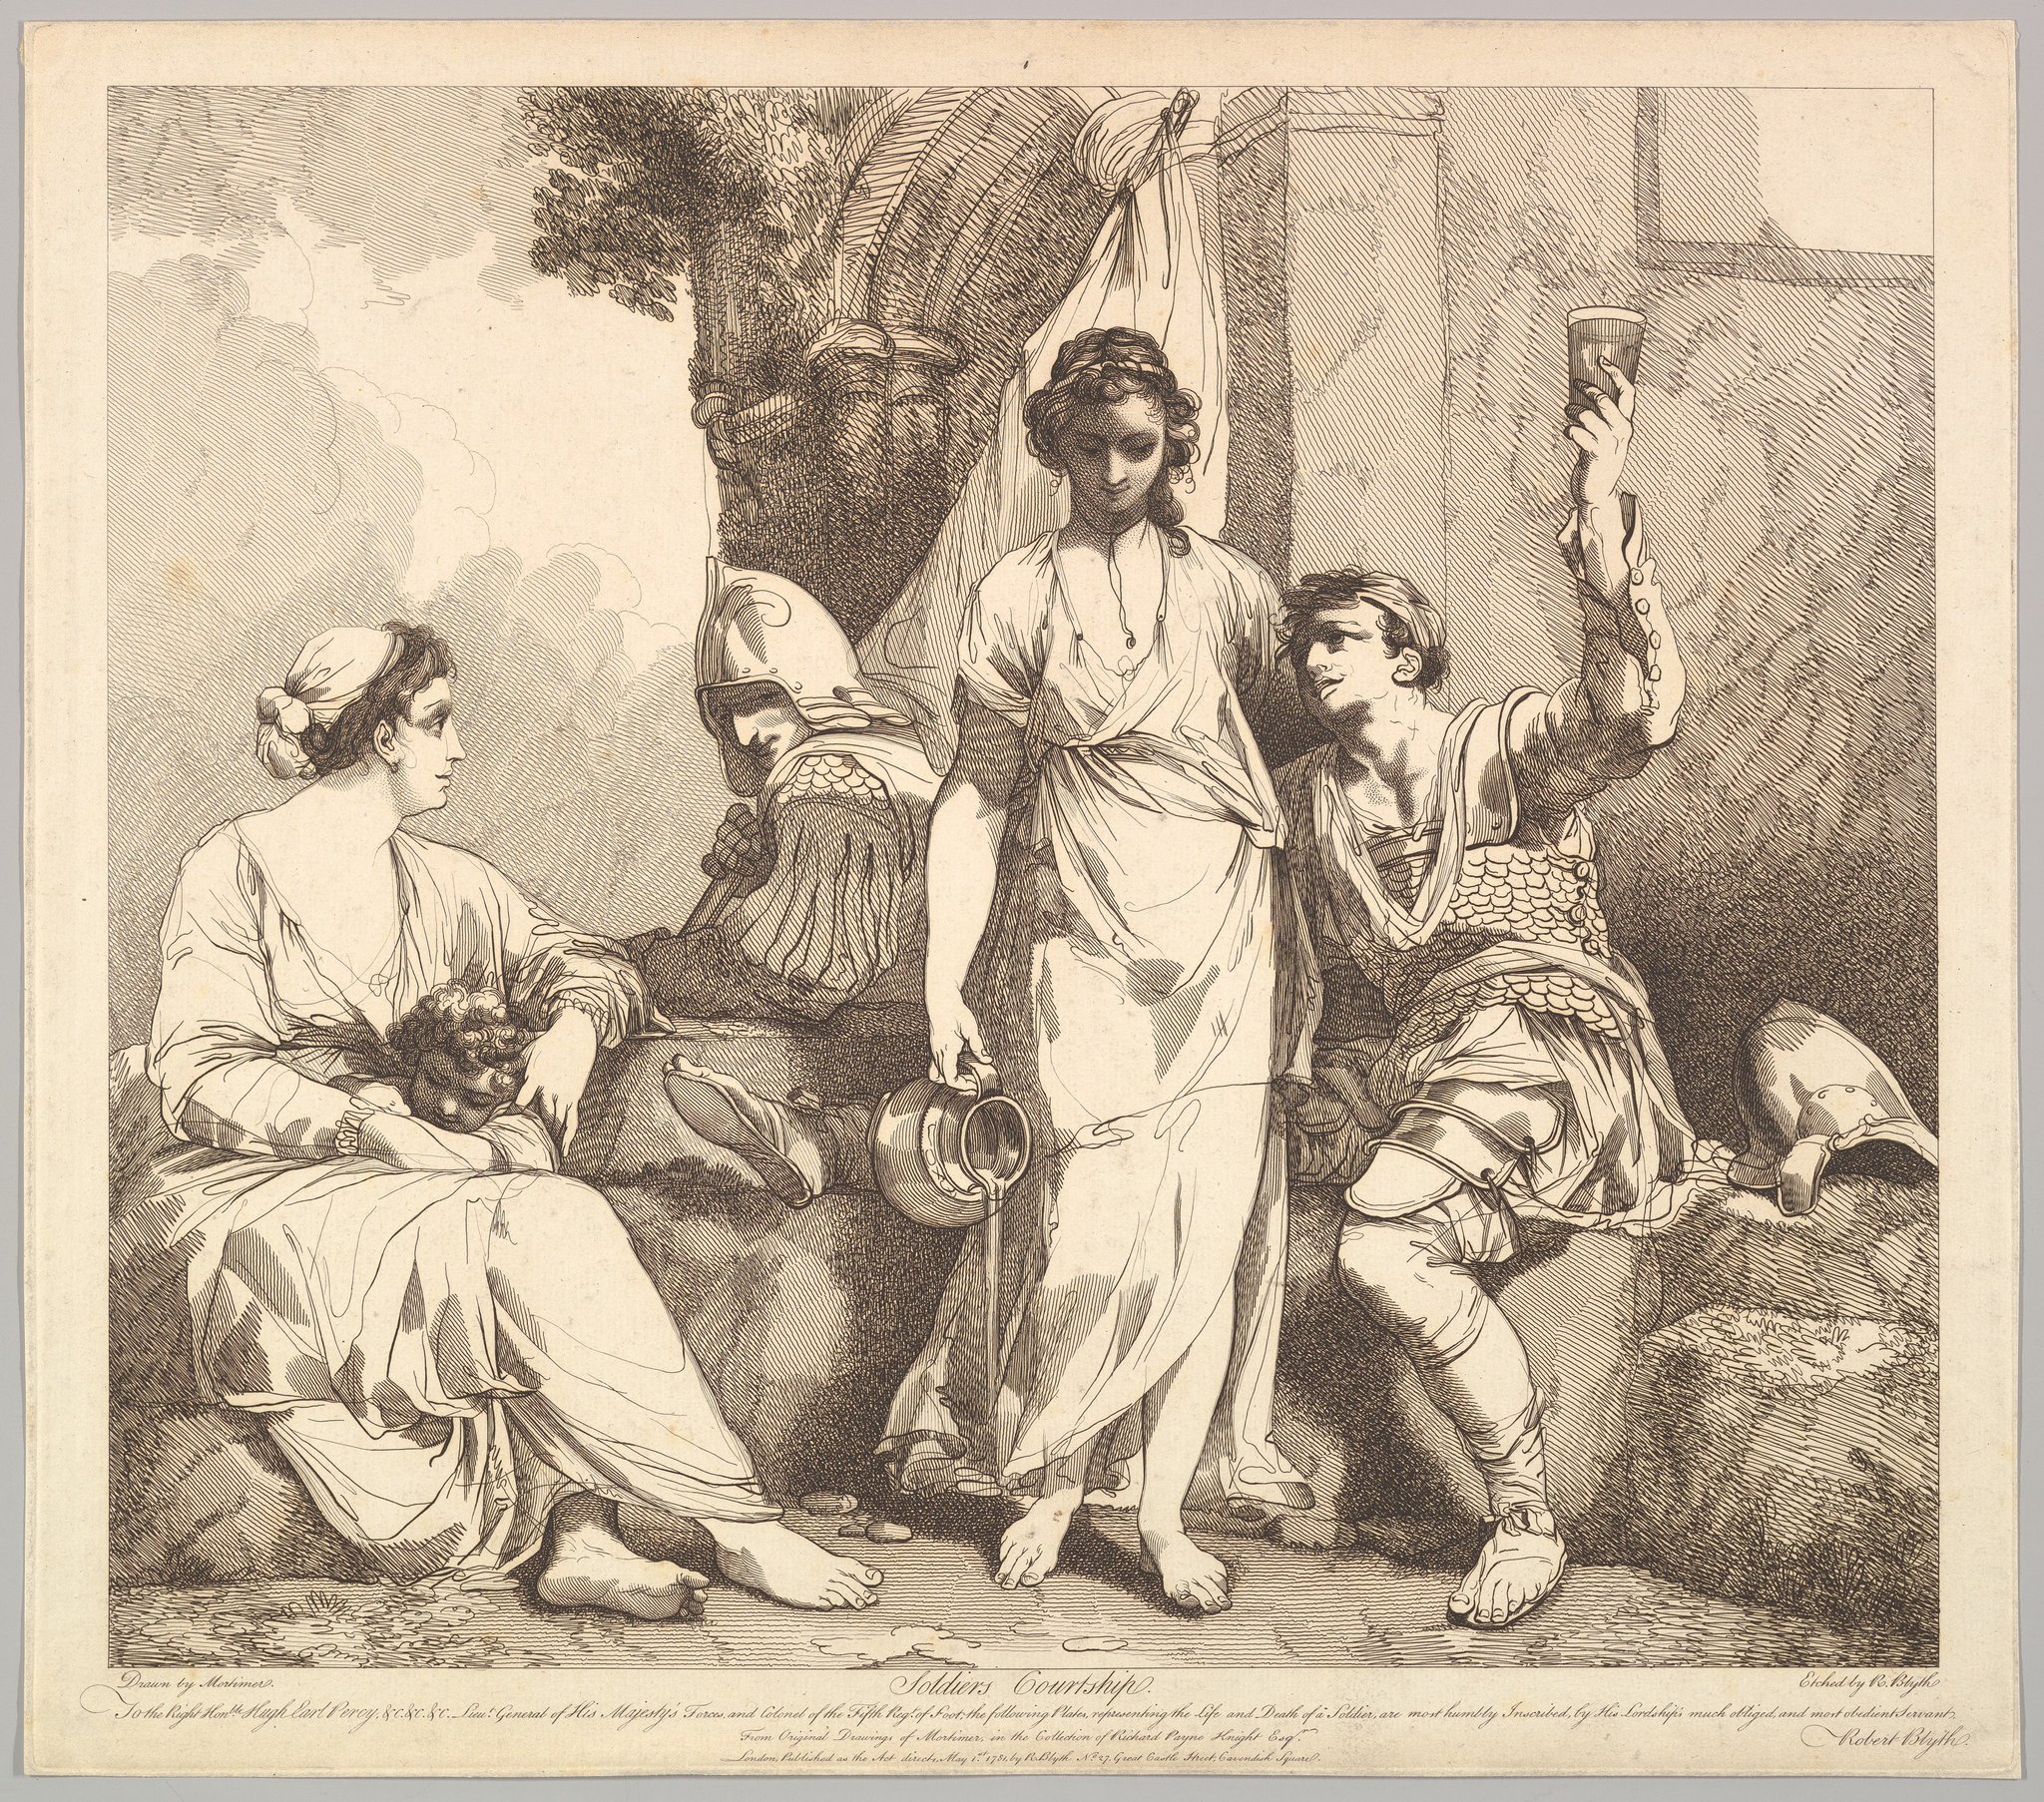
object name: print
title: Soldier's Courtship, from "The Life and Death of a Soldier"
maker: robert blyth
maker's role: artist and publisher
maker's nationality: british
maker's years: 1750-1784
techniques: etching, stippling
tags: soldiers,children,men,women